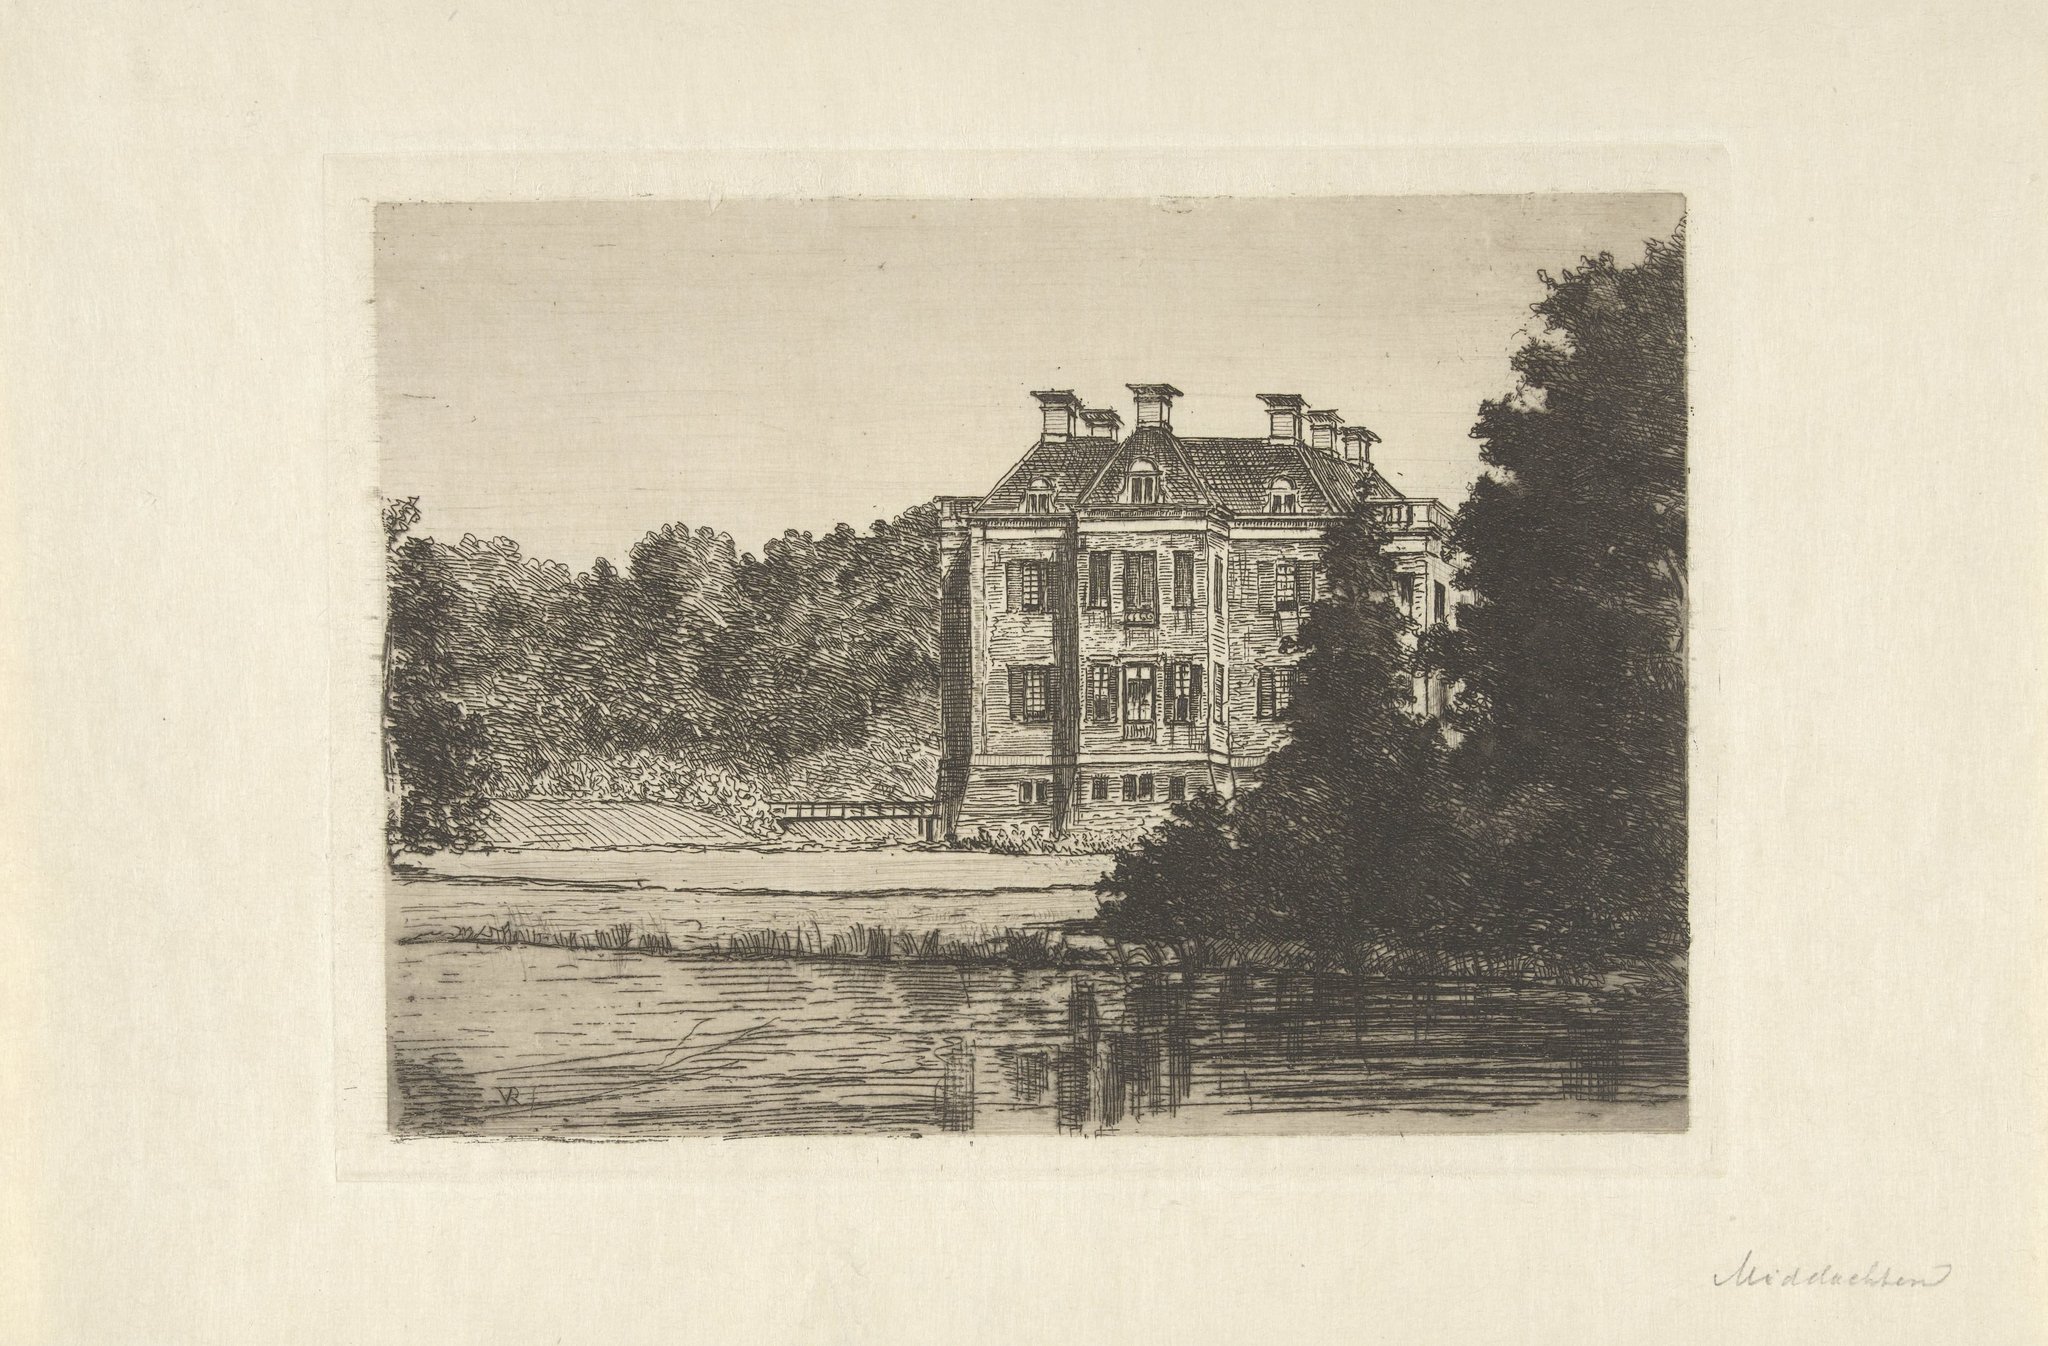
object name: print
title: Kasteel Middachten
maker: jonkheer barthold willem floris van riemsdijk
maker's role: engineer, print maker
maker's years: 1850-1942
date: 1865-1918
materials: paper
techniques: drypoint, etching, intaglio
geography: netherlands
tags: farm or solitary house in landscape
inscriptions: collector's mark: Lugt 2228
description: Gezicht vanaf het water op de zijkant van kasteel Middachten.